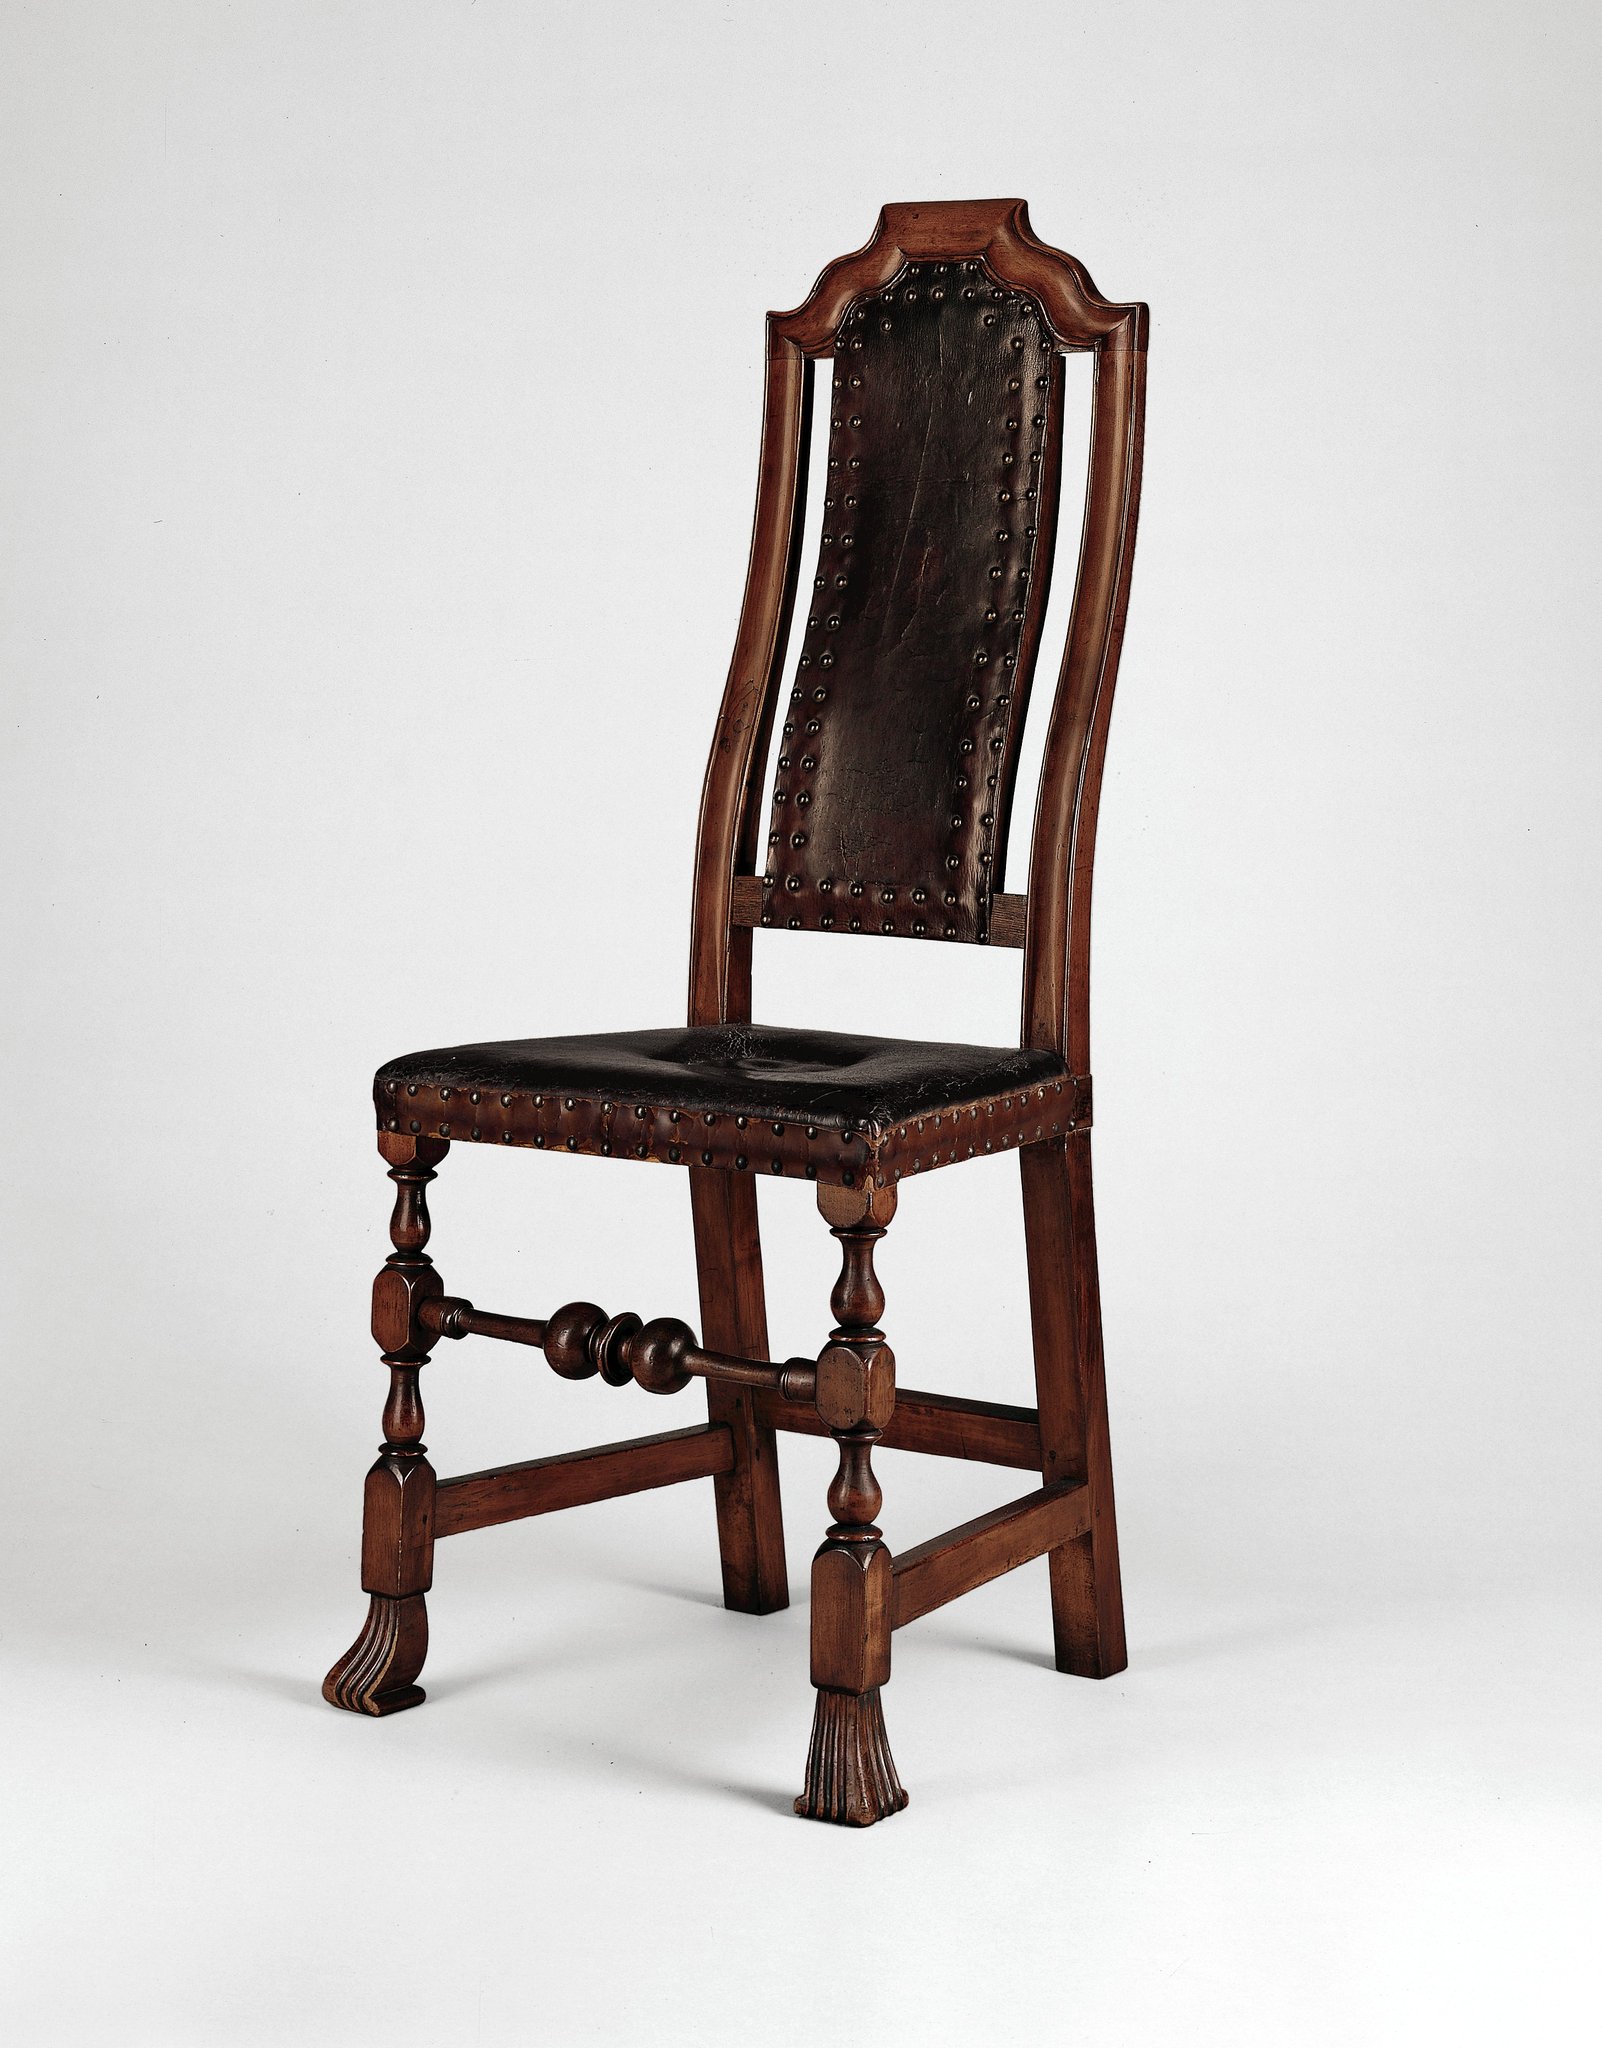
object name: chair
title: Leather chair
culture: american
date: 1723-1745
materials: wood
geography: united states